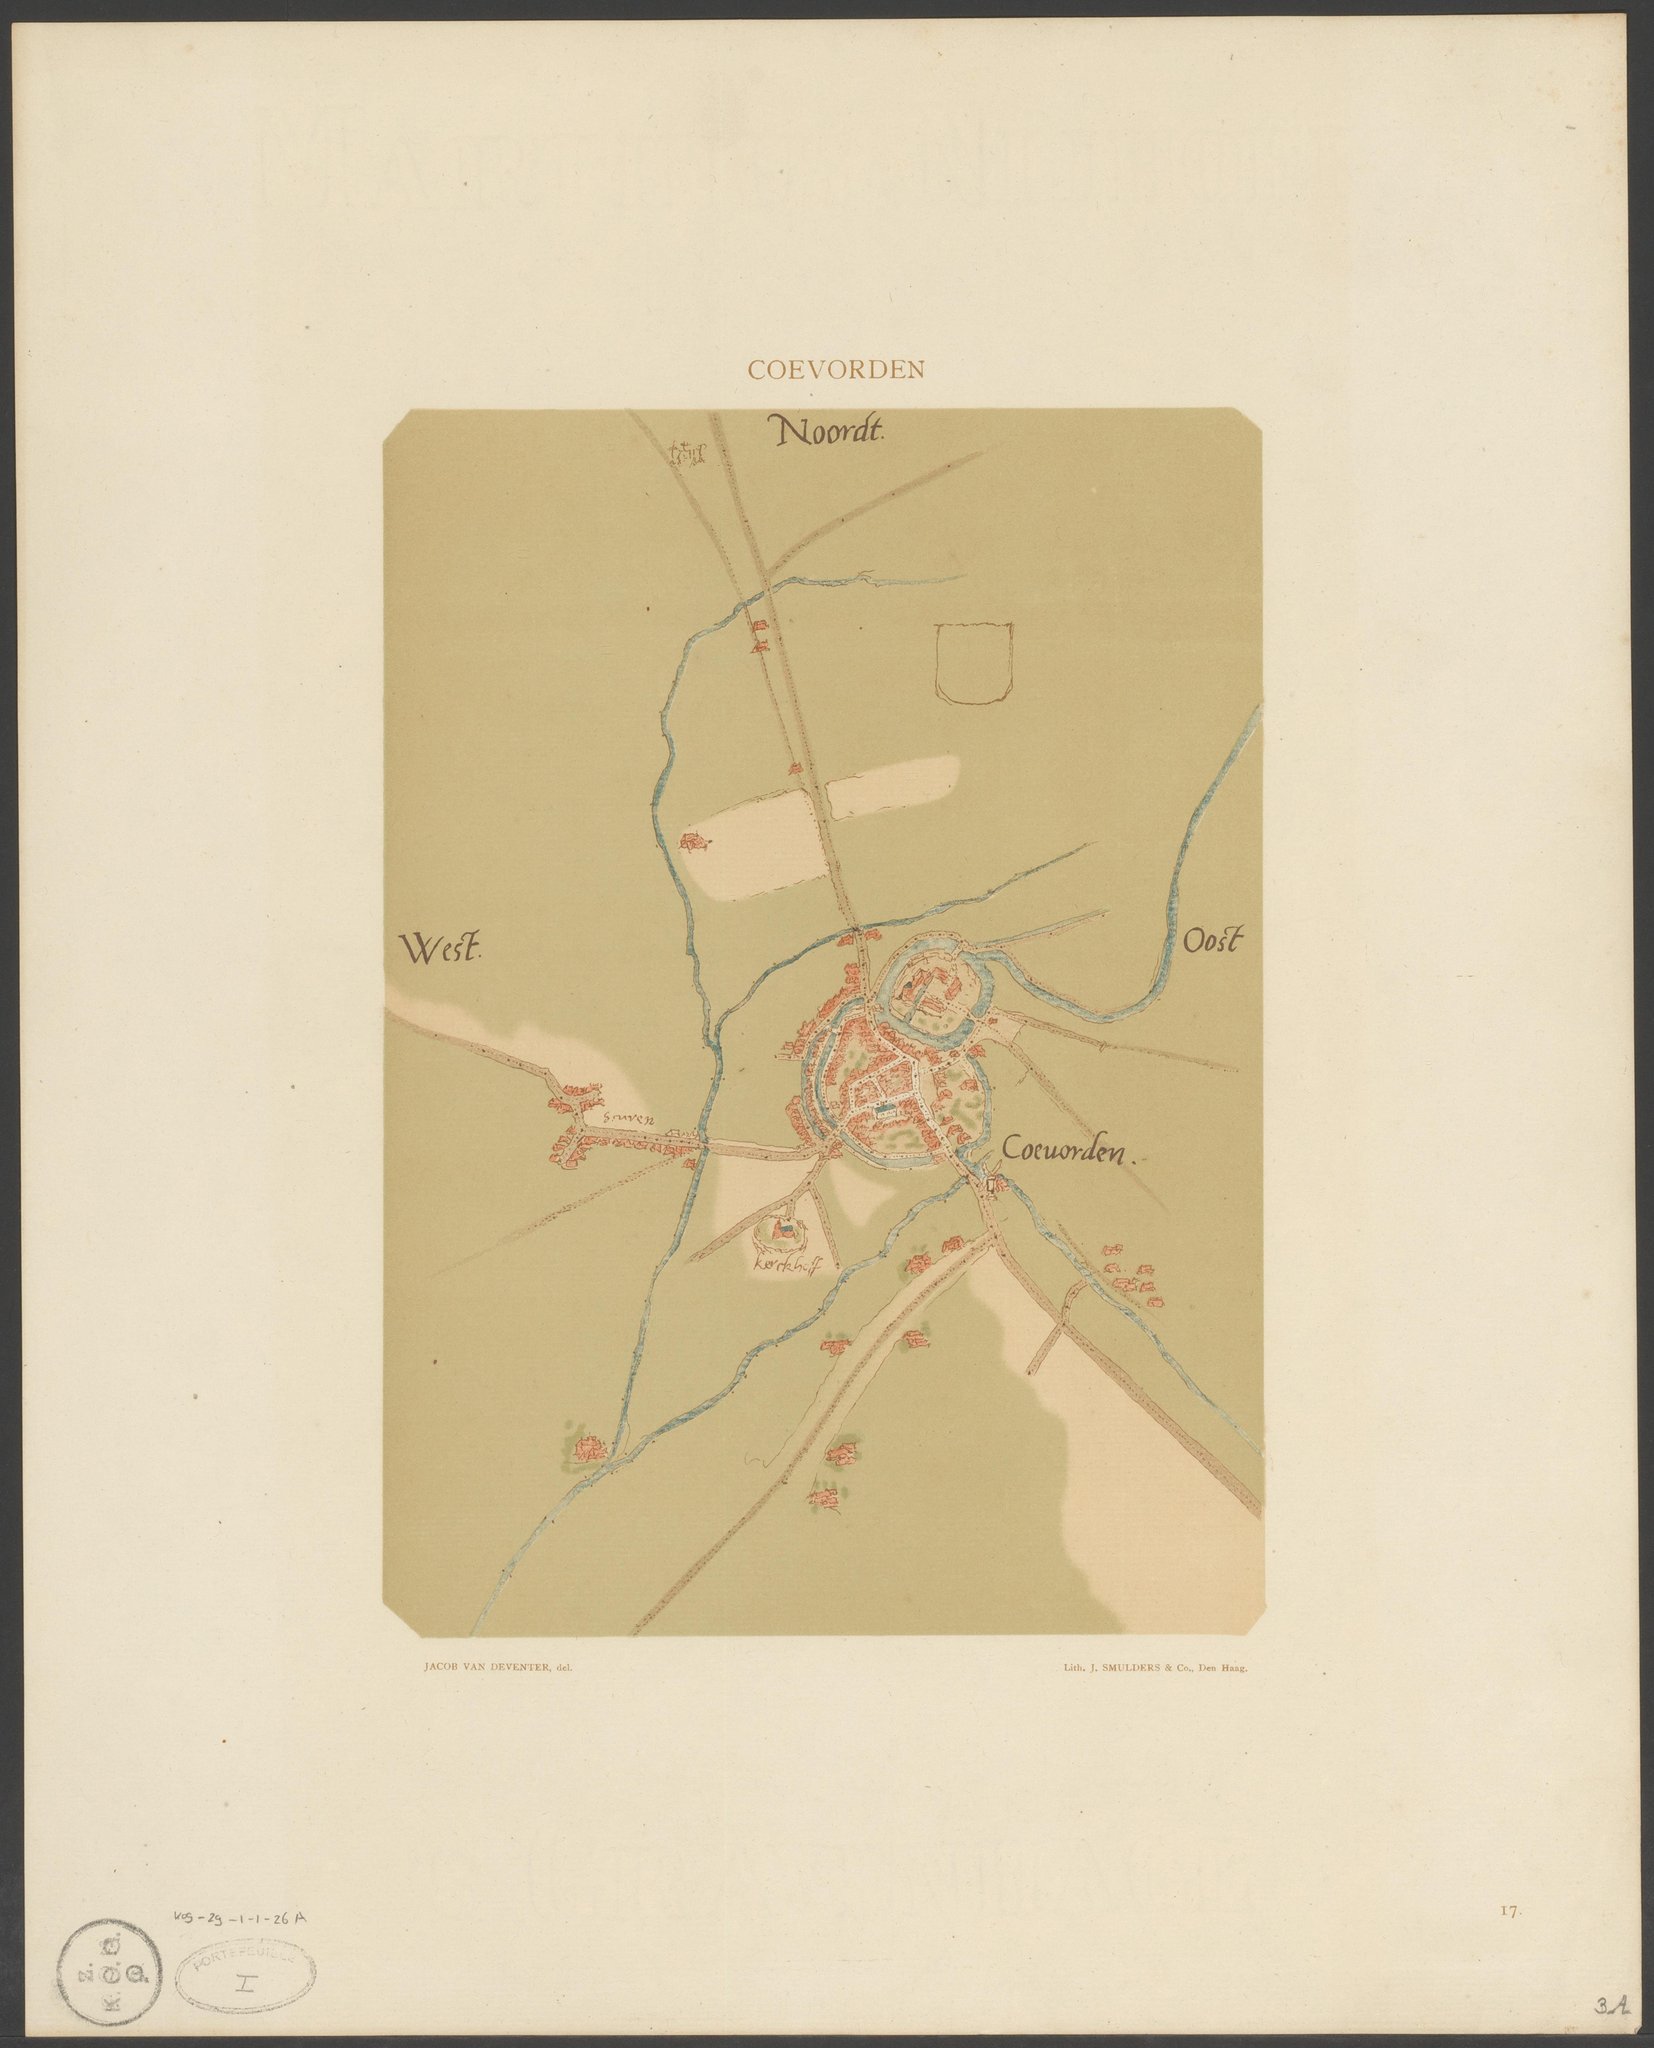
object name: area plan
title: Plattegrond van Coevorden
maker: jacob van deventer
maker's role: draughtsman, print maker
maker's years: 1510-1575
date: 1916-1923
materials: paper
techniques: lithograph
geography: the hague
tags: maps of cities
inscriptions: collector's mark, collector's mark: Lugt 1641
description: Plattegrond van de stad Coevorden. Genummerd rechtsonder: 17. Onderdeel van een serie 'Nederlandsche Steden in de 16e eeuw', reproducties naar de oorspronkelijke topografische tekeningen van Jacob van Deventer. Onderwerpsrubrieken binnen de Atlas Zeden en Gewoonten: topografie; stadsplattegronden.